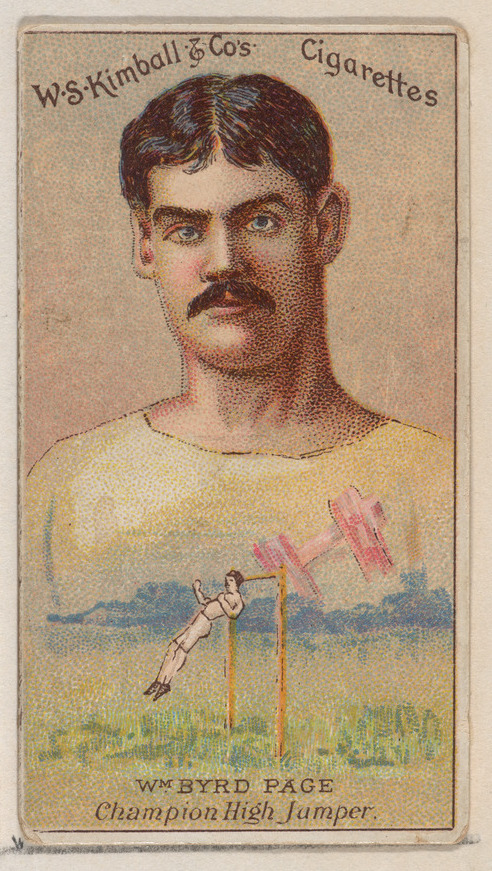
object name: print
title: William Byrd Page, Champion High Jumper, from the Champions of Games and Sports series (N184, Type 1) issued by W.S. Kimball & Co.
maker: w.s. kimball & co.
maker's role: publisher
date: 1887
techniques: color lithograph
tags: men,sports,athletes